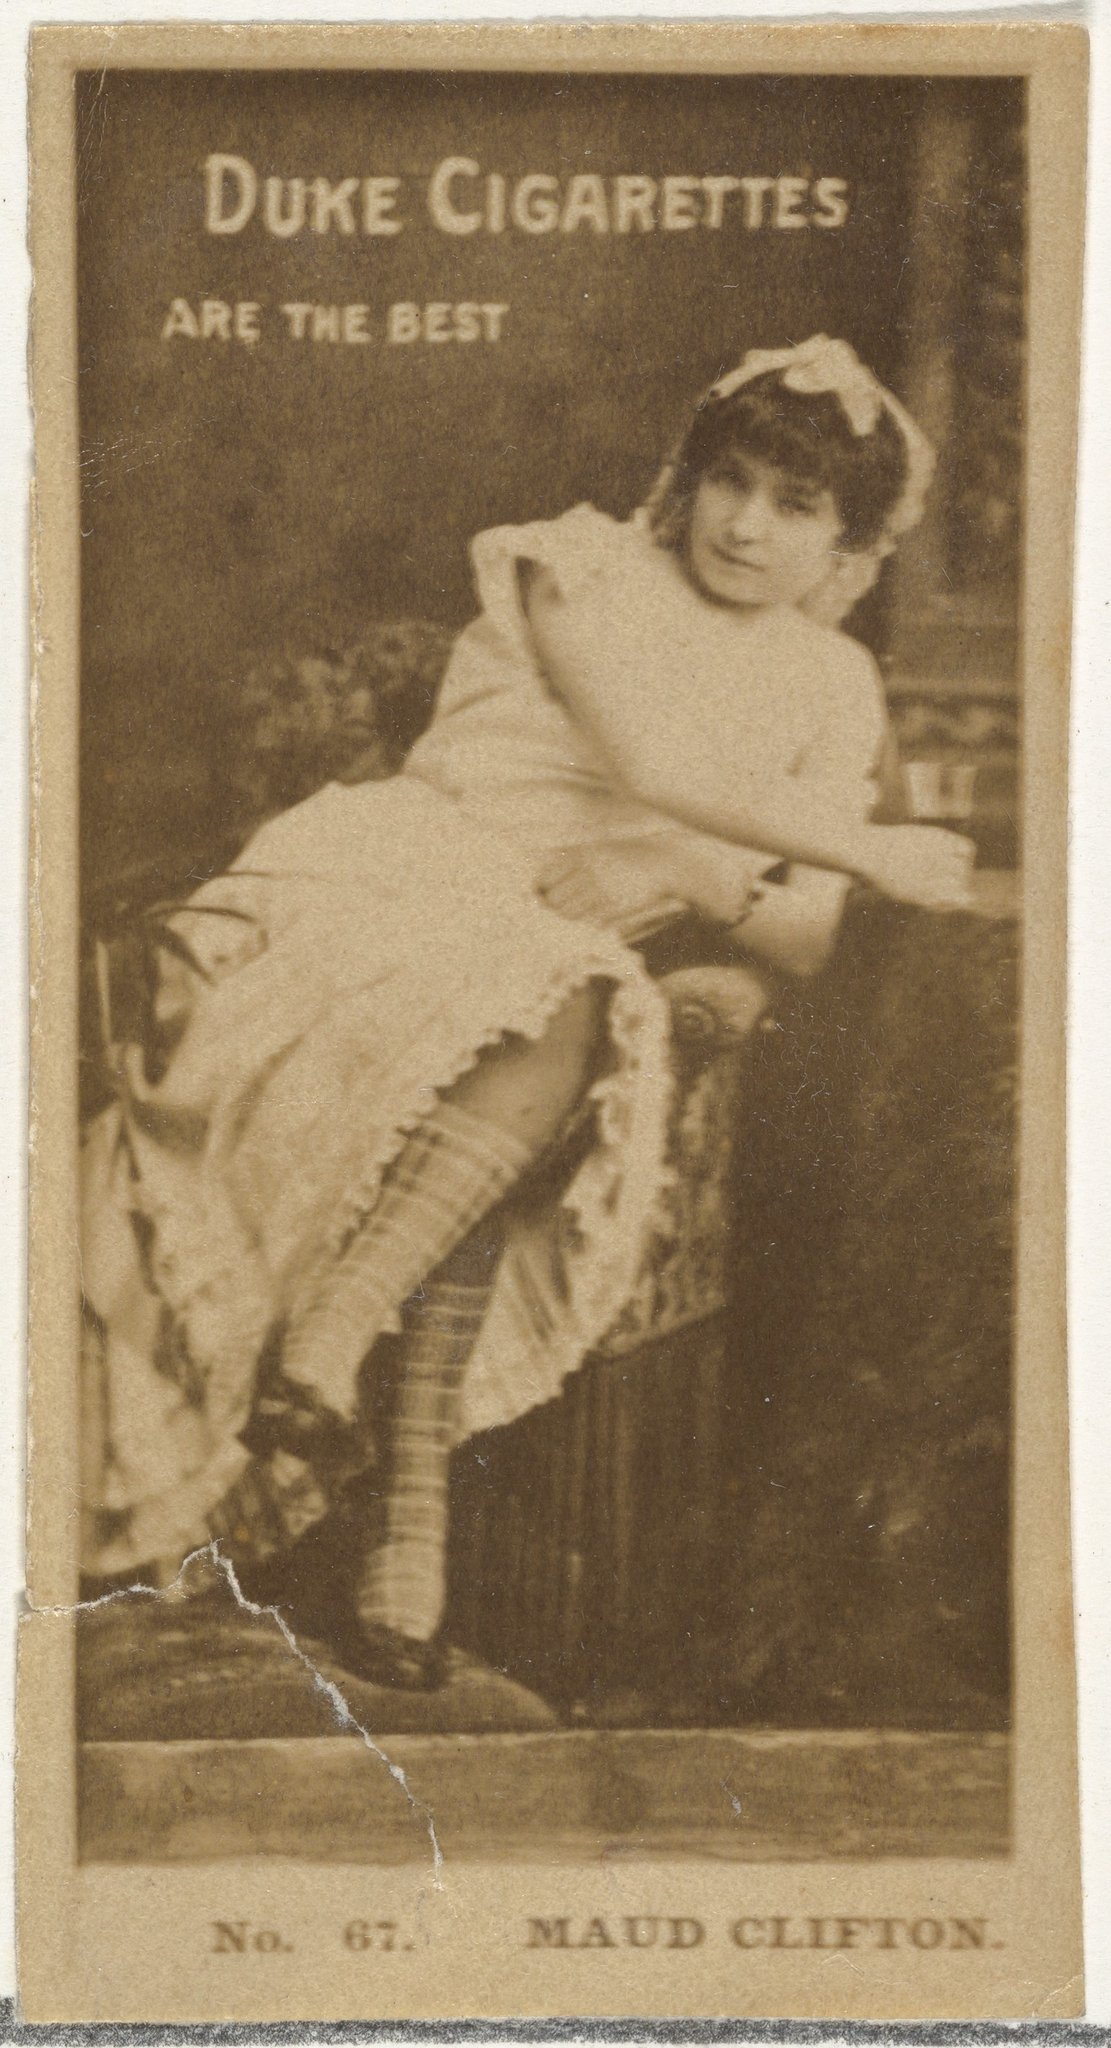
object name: photograph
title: Card Number 67, Maud Clifton, from the Actors and Actresses series (N145-6) issued by Duke Sons & Co. to promote Duke Cigarettes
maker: w. duke, sons & co.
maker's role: publisher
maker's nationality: american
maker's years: 1870-1920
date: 1880-1889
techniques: albumen silver print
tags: portraits,women,actresses